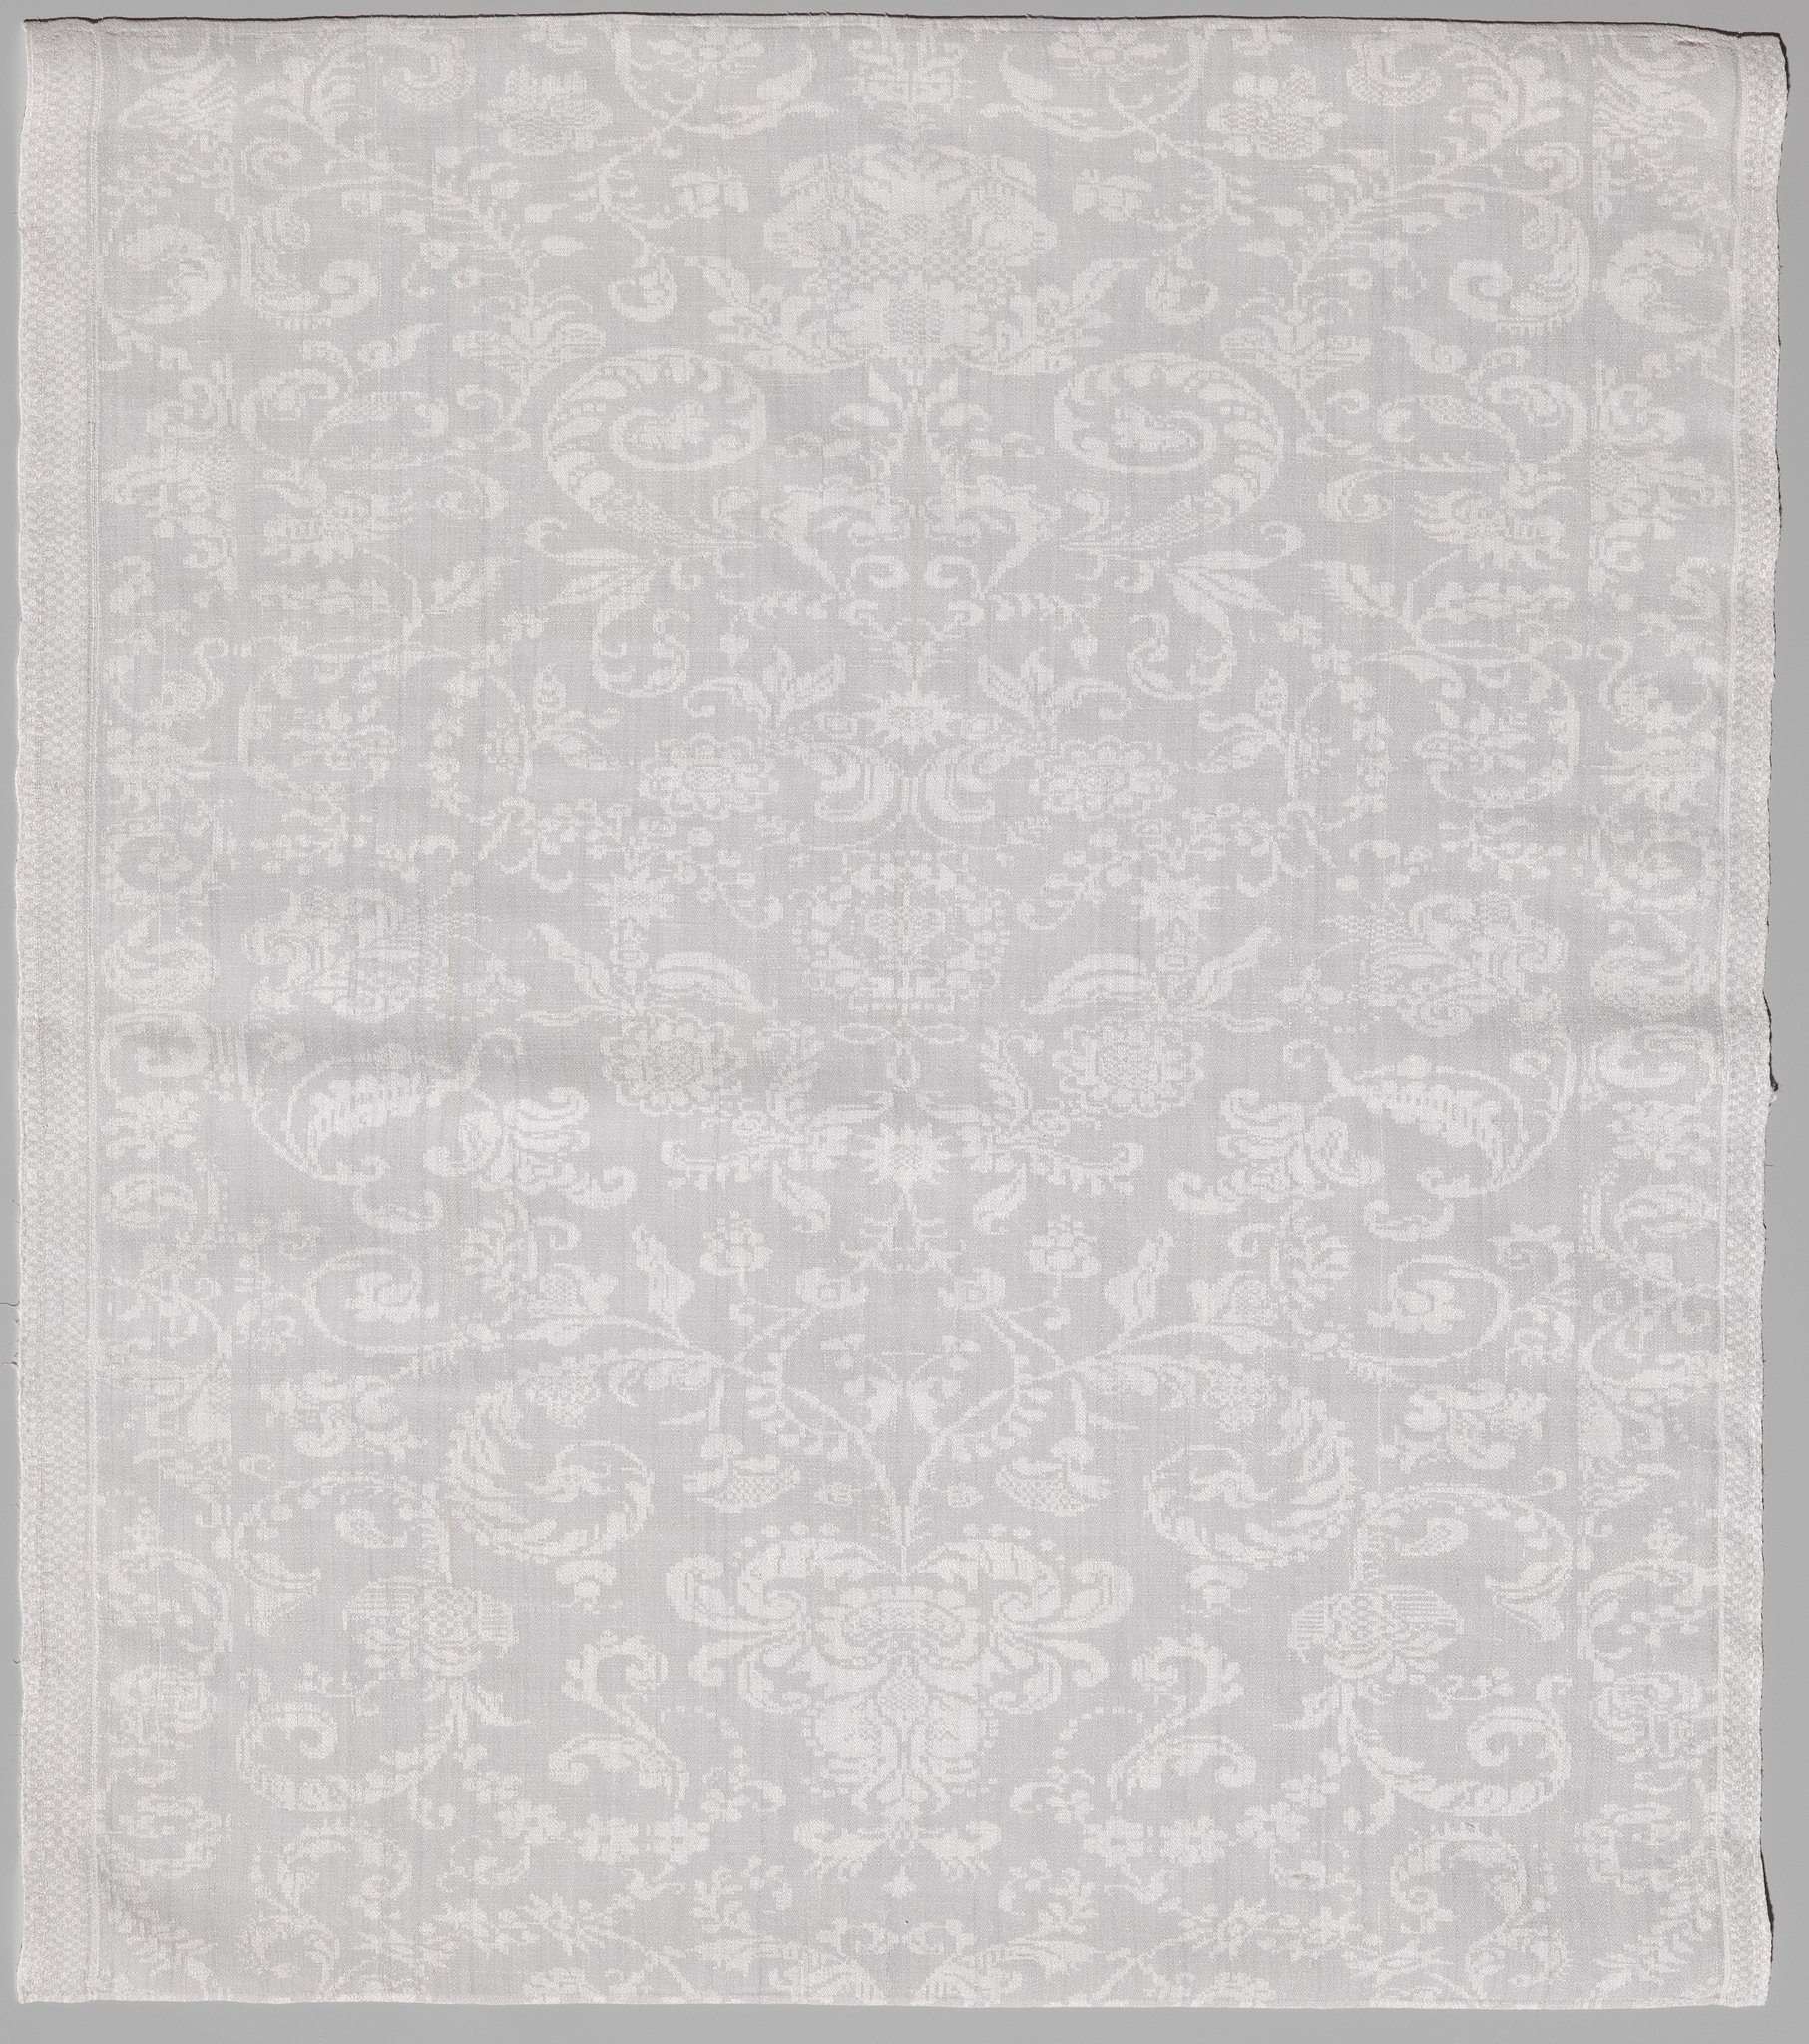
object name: napkin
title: Servet van wit linnendamast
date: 1675-1699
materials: linen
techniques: damask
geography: flanders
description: Wit linnendamasten servet met een patroon van bloemranken en bloemornamenten, merk HB 20.